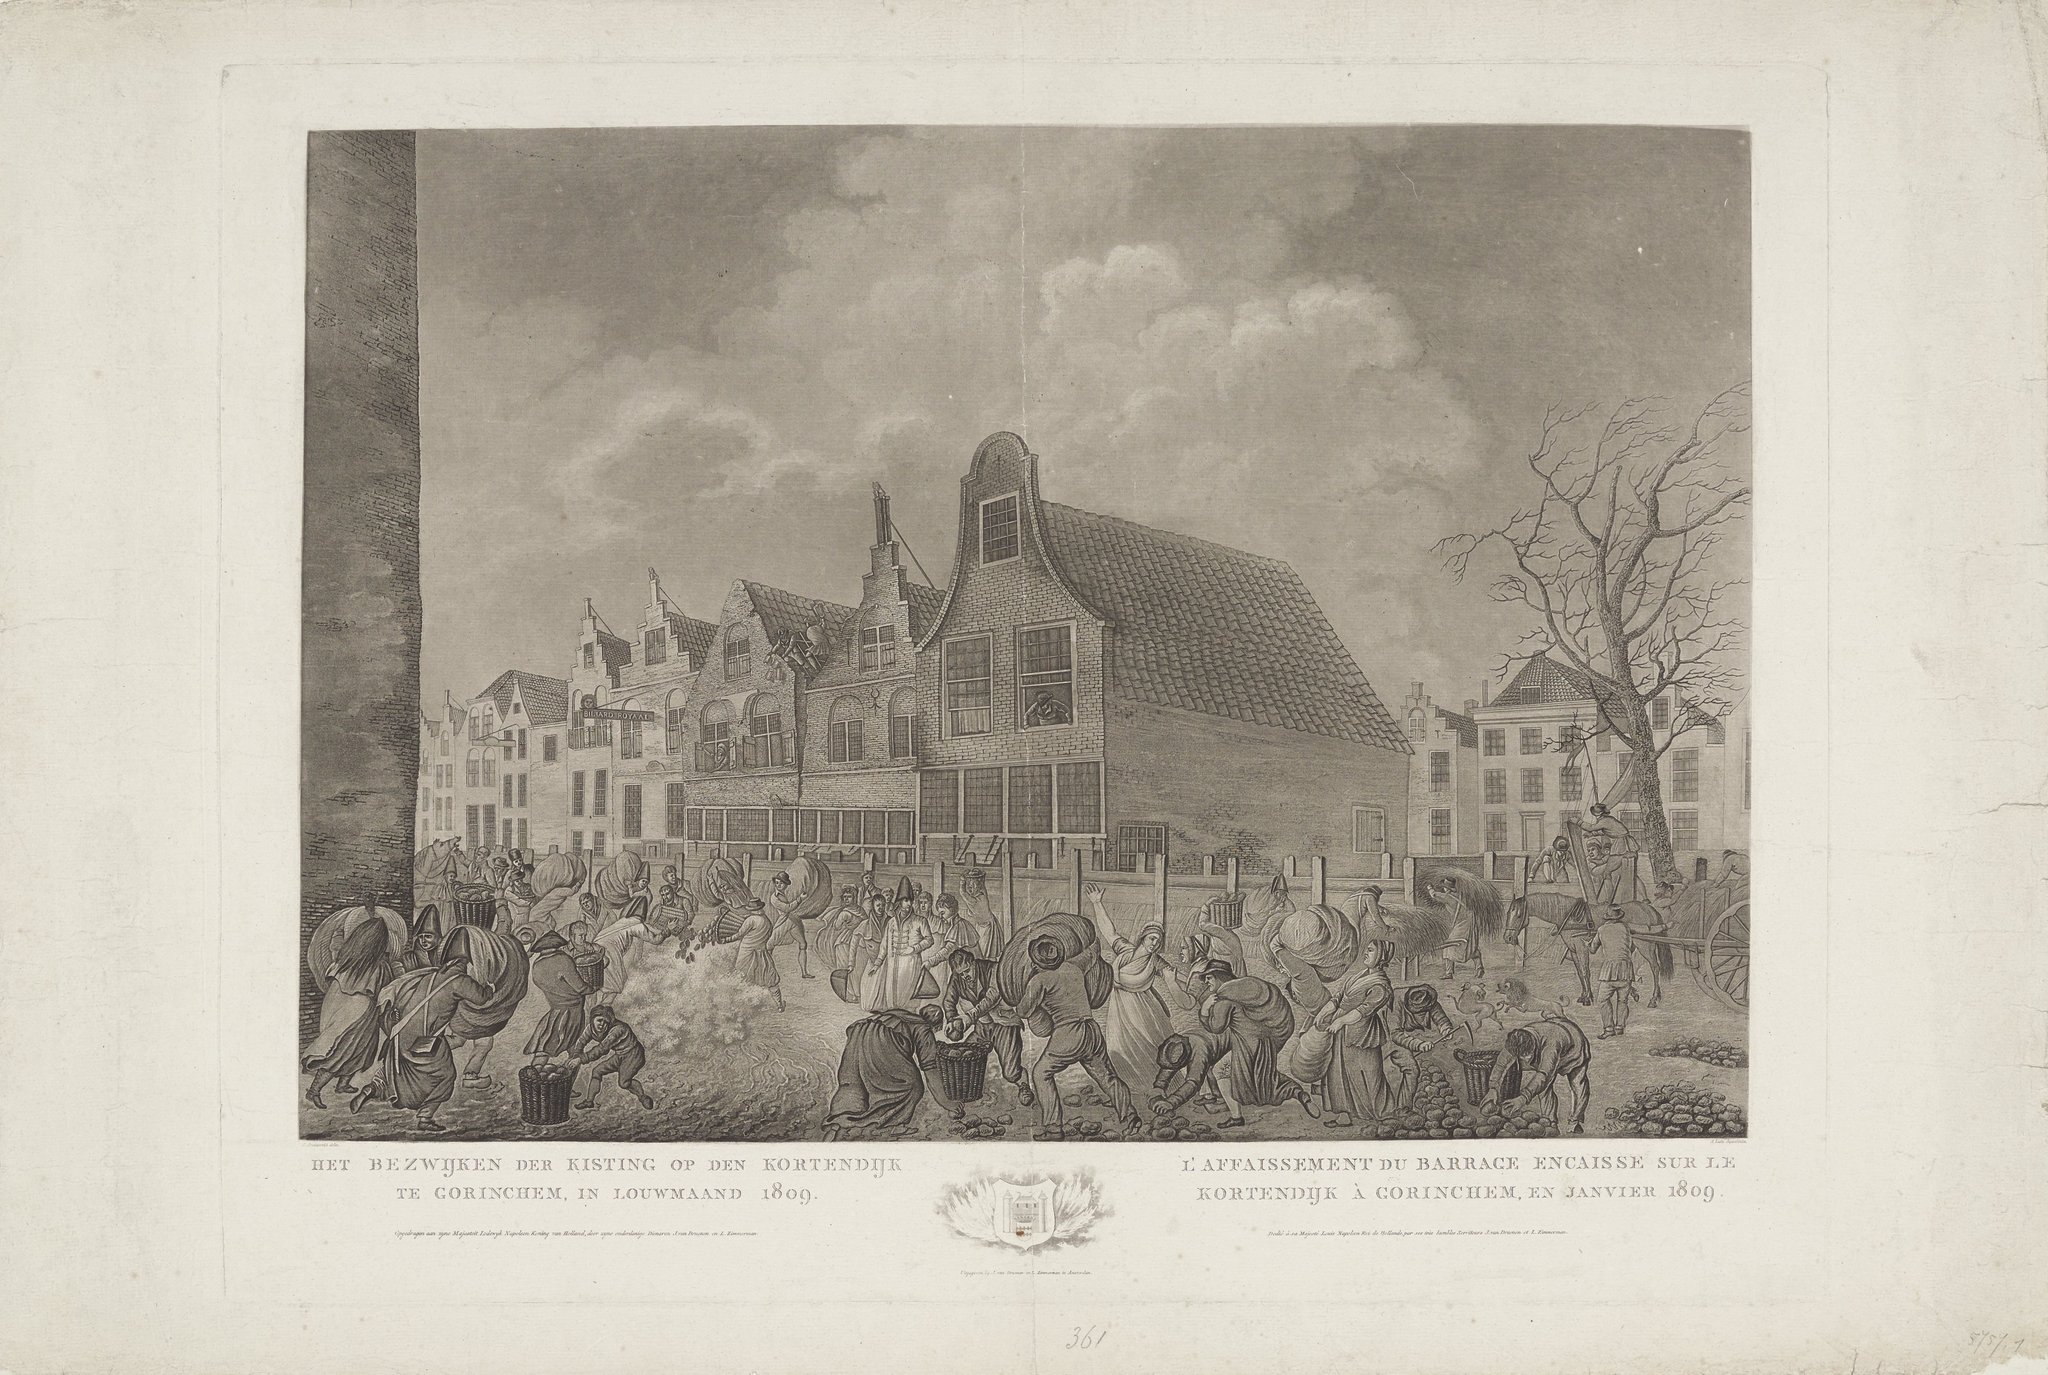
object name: print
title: Vier platen van de watersnood in 1809 opgedragen aan koning Lodewijk Napoleon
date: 1809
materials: paper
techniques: aquatint, etching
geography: netherlands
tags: dike-break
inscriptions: collector's mark: Lugt 2228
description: Watersnood in de straten van de stad Gorinchem als de bekisting langs de Kortendijk bezwijkt, januari 1809. Mensen dragen stenen en dakpannen aan om de doorbraak te stoppen. Onderaan de titels in het Nederlands en Frans gescheiden door het stadswapen van Gorinchem. Onderdeel van een serie van vier platen van de watersnood van januari 1809.